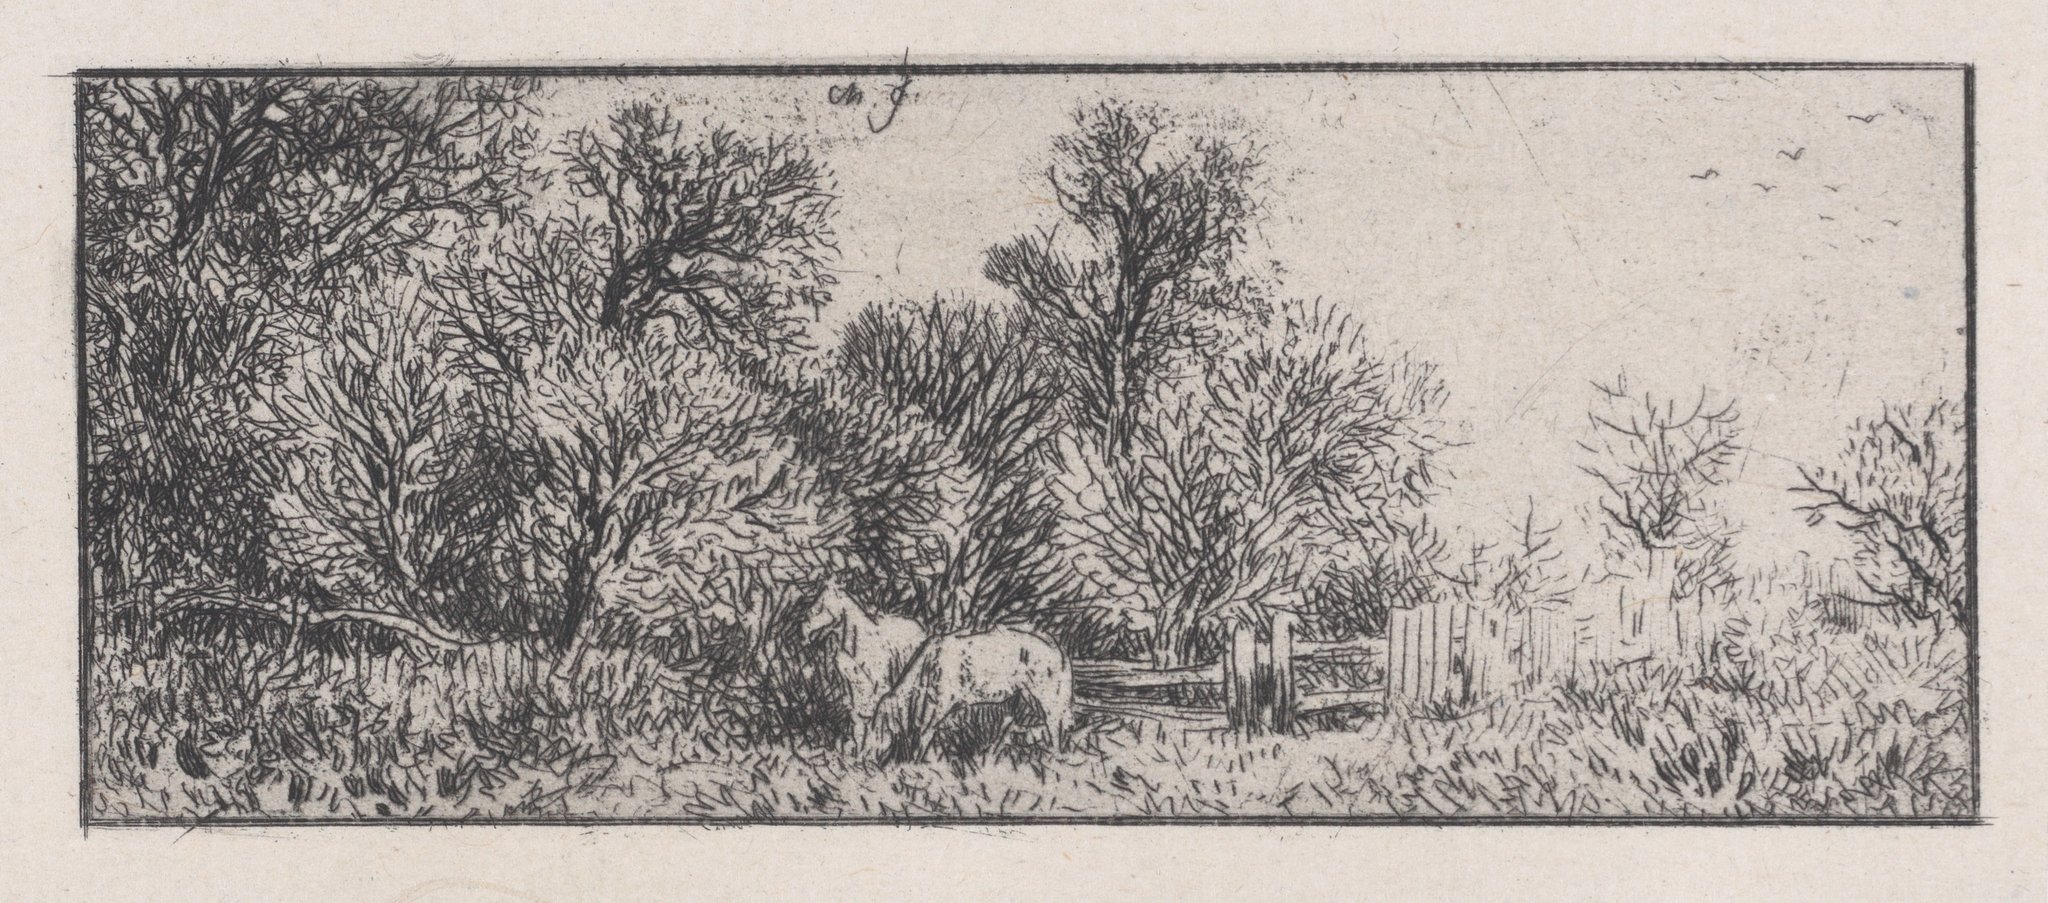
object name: print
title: Landscape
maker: charles émile jacque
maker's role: artist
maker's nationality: french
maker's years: 1813-1894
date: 1848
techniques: drypoint